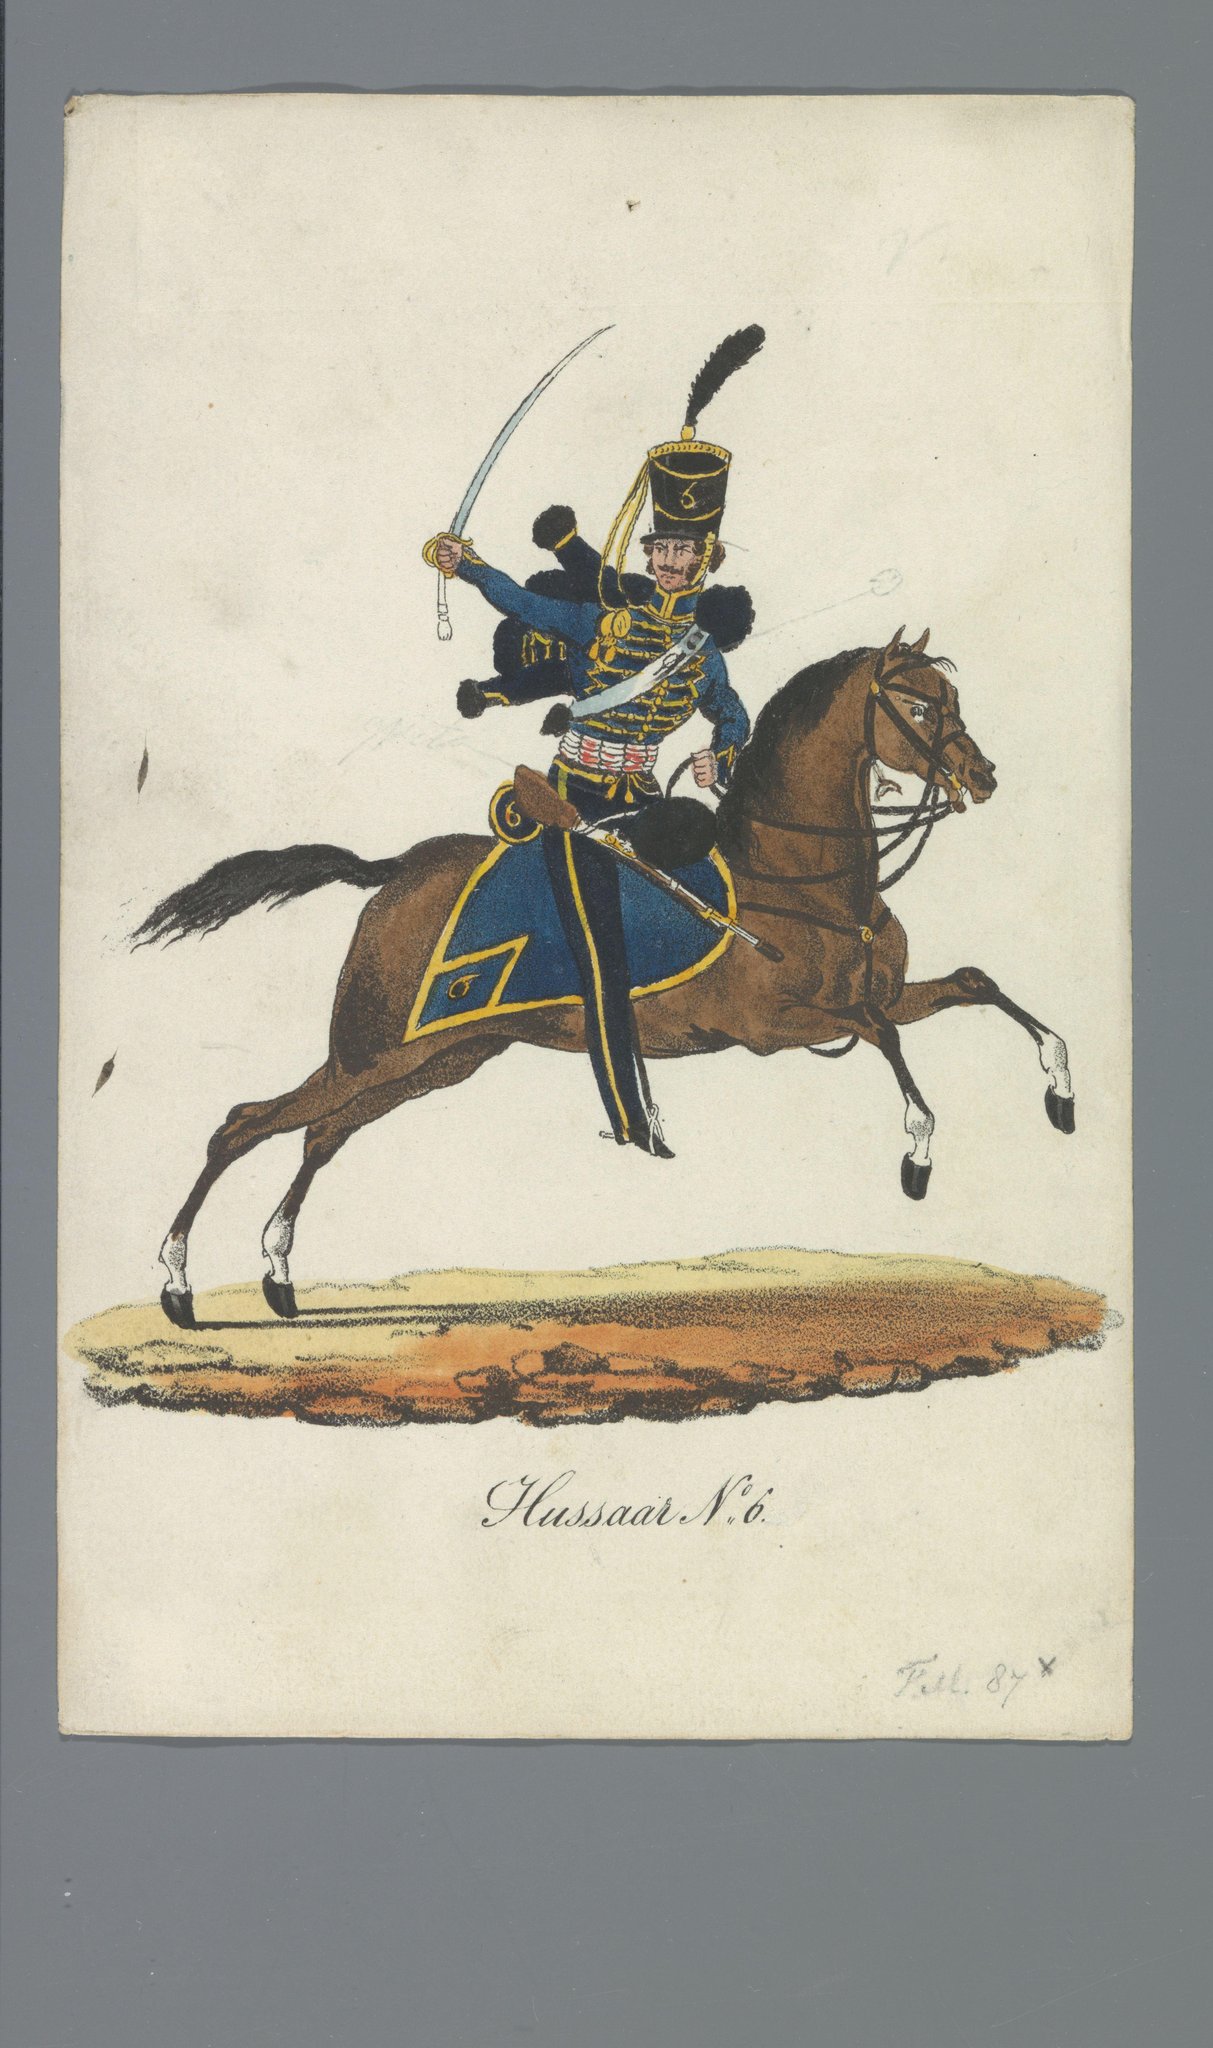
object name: print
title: Hussaar No. 6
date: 1835-1850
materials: paper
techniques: hand coloring, lithograph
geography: utrecht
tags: (military) uniforms, clothes, costume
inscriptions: collector's mark: Lugt 2228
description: Een huzaar van het Regiment Huzaren Nr 6, te paard. Onderdeel van een serie van 157 losse bladen met Nederlandse militaire uniformen in de jaren 1830-1832.